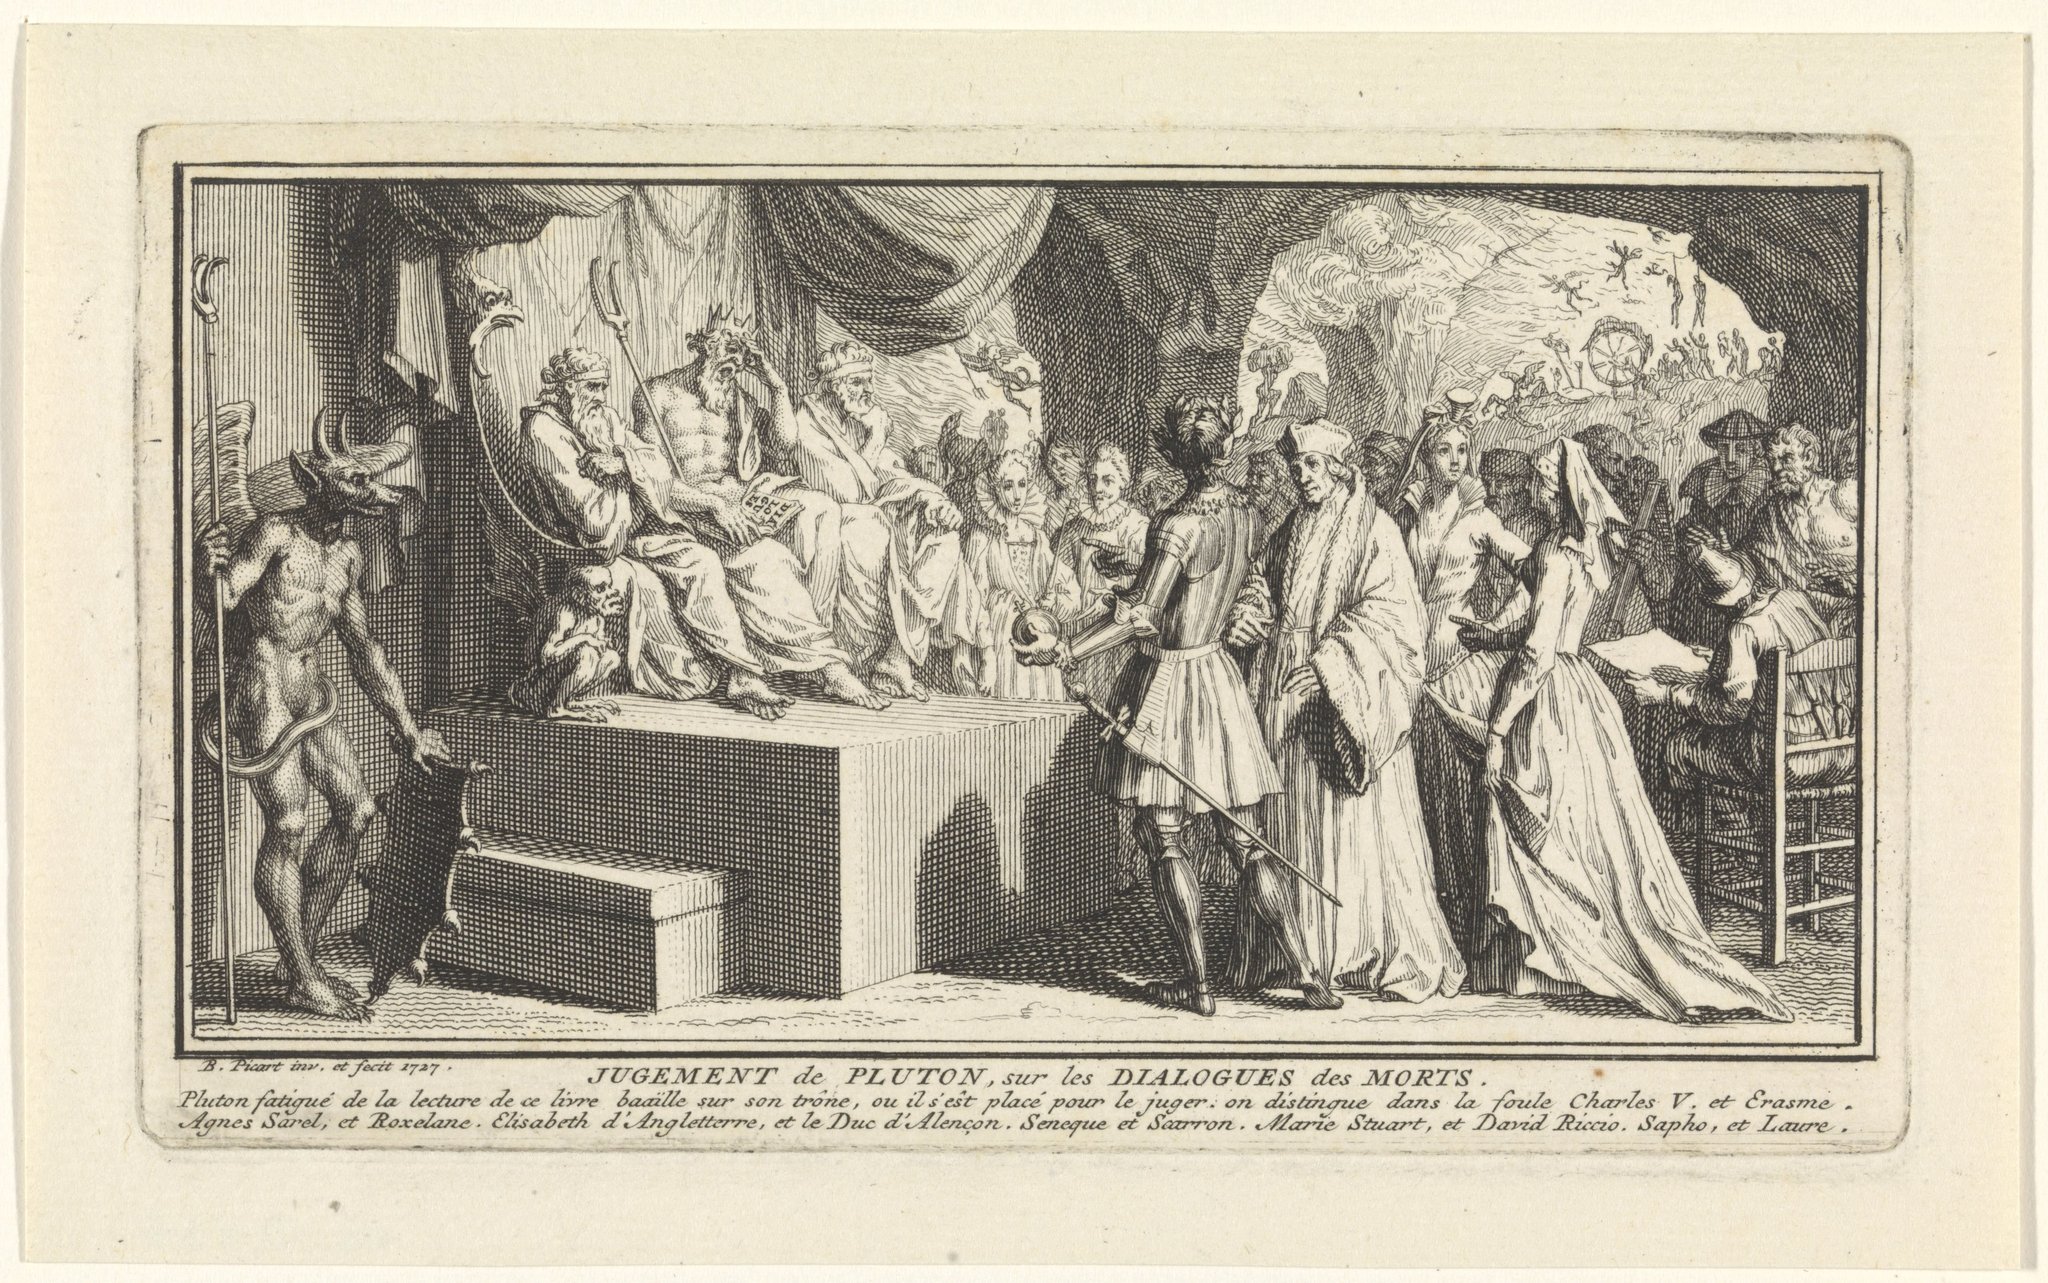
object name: print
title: Oordeel van Pluto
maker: bernard picart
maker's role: draughtsman, print maker, publisher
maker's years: 1673-1733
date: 1727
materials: paper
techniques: engraving, etching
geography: amsterdam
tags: desiderius erasmus, pluto as king of the underworld, tartarus (and the condemned assigned there)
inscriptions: collector's mark: Lugt 2228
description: Pluto, de god van de onderwereld, zit op zijn troon om te oordelen over de zielen van de gestorvenen. Een processie van overleden historische personen - onder wie Erasmus - heeft zich voor hem verzameld. Op de achtergrond de Tartarus, het gedeelte van de onderwereld waar de verdoemden gestraft worden. In de marge een tweeregelig onderschrift in het Frans.